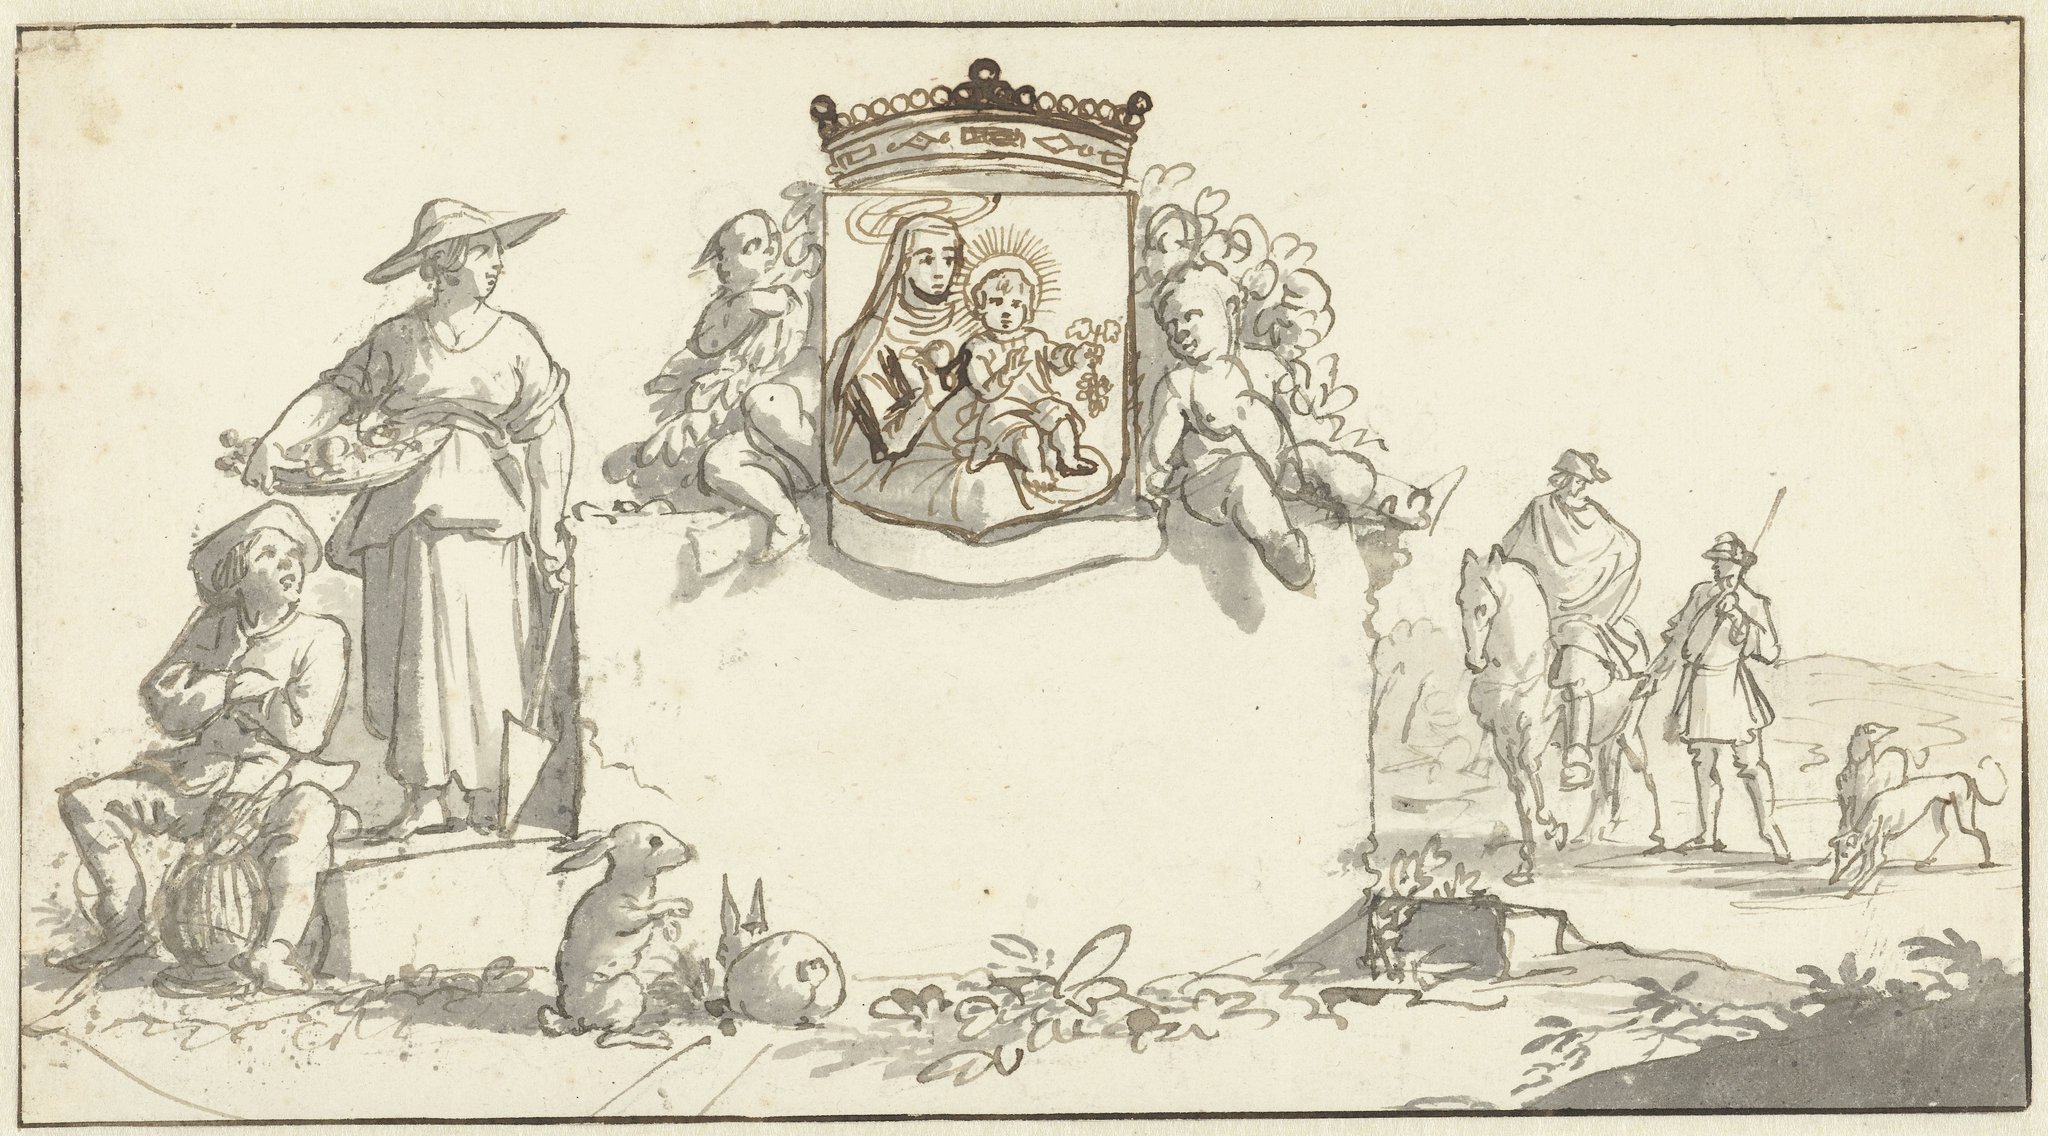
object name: design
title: Ontwerp voor een titelblad met een wapen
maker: caspar luyken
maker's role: draughtsman, print maker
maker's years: 1672-1708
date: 1682-1708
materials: ink, paper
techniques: brush, pen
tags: coat of arms (as symbol of the state, etc.), christ-child holding something in his hand, e.g. apple, bird, cherries, crucifix, grapes, paper wind-mill ~ madonna-representations, farmers, rodents: rabbit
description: Ontwerp voor een titelblad met een wapen met Maria en kind boven een gedenksteen; links en rechts bevinden zich personen.